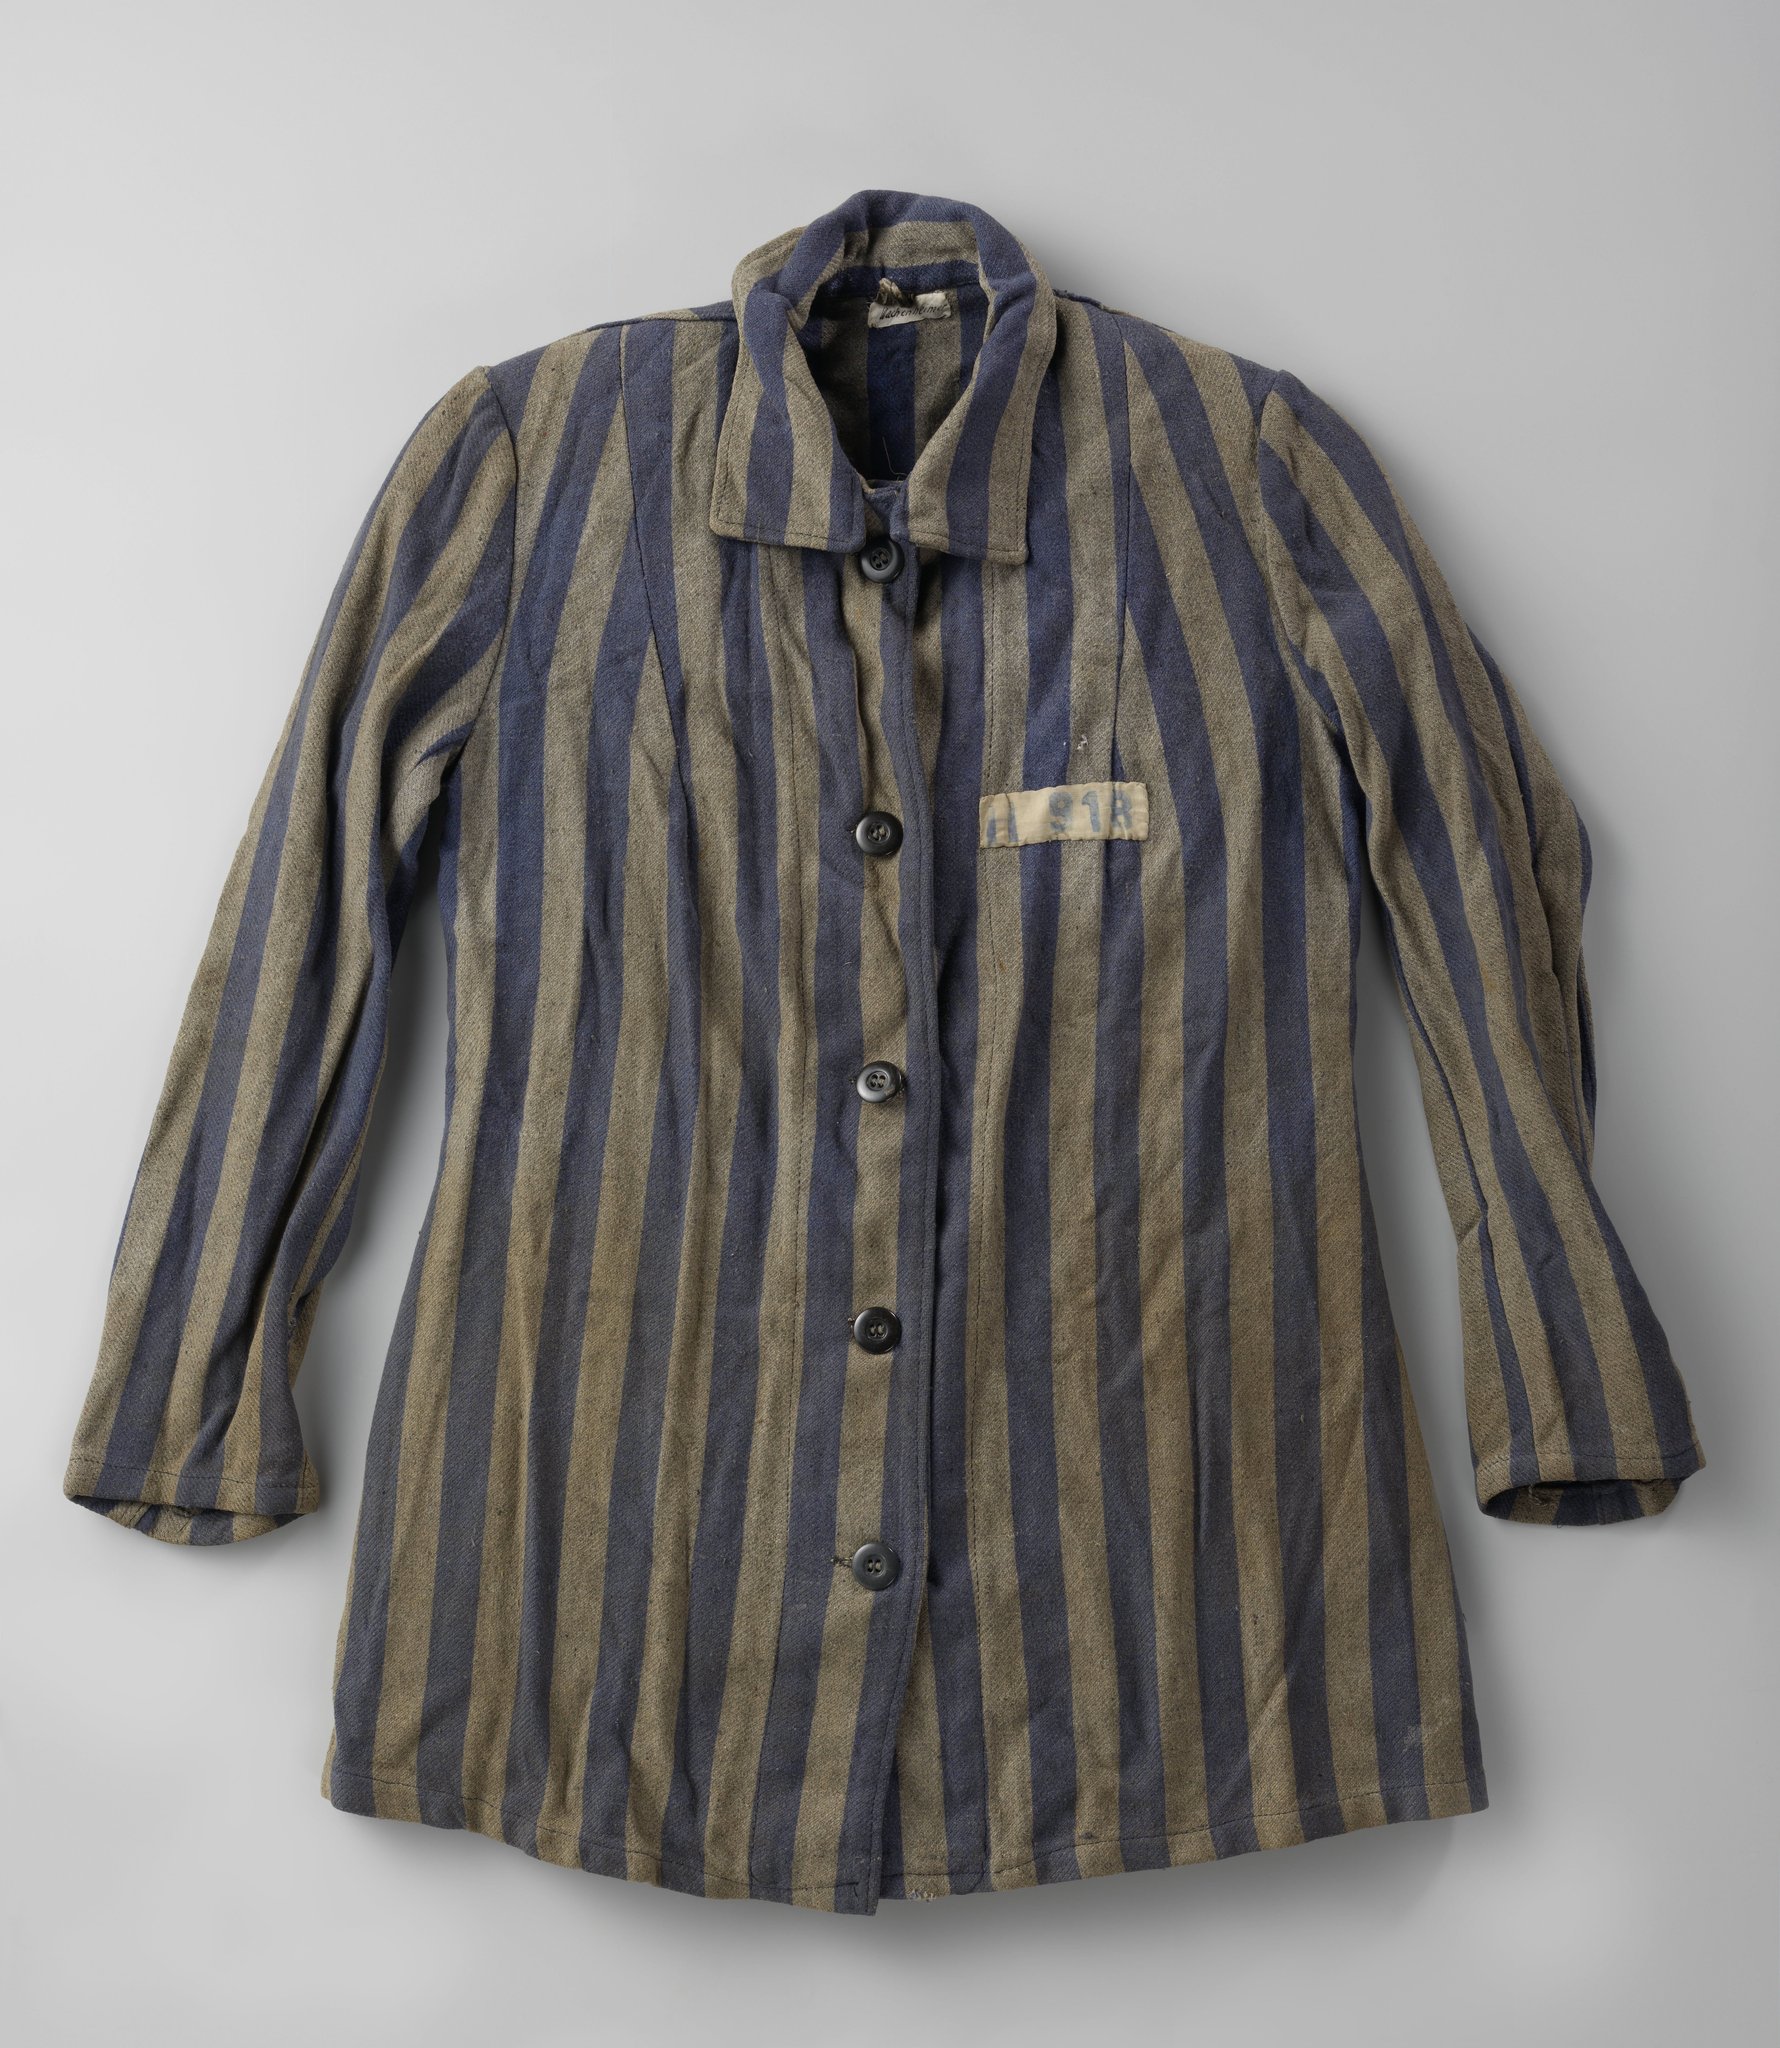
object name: coat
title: Concentration camp coat, worn by Isabel Wachenheimer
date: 1938-1945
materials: plastic, wool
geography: germany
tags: tweede wereldoorlog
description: Isabel Wachenheimer (1928-2010) wore this numbered prison coat at Lenzing-Pettighofen concentration camp in Austria. She had been transferred to this labour camp from Auschwitz death camp along with 500 other Jewish women in October 1944. This was just after Isabel’s parents, Eugen and Else Wachenheimer, had been murdered in Auschwitz. After the war, Isabel sewed her surname on the coat. A label under the collar states: Wachenheimer.